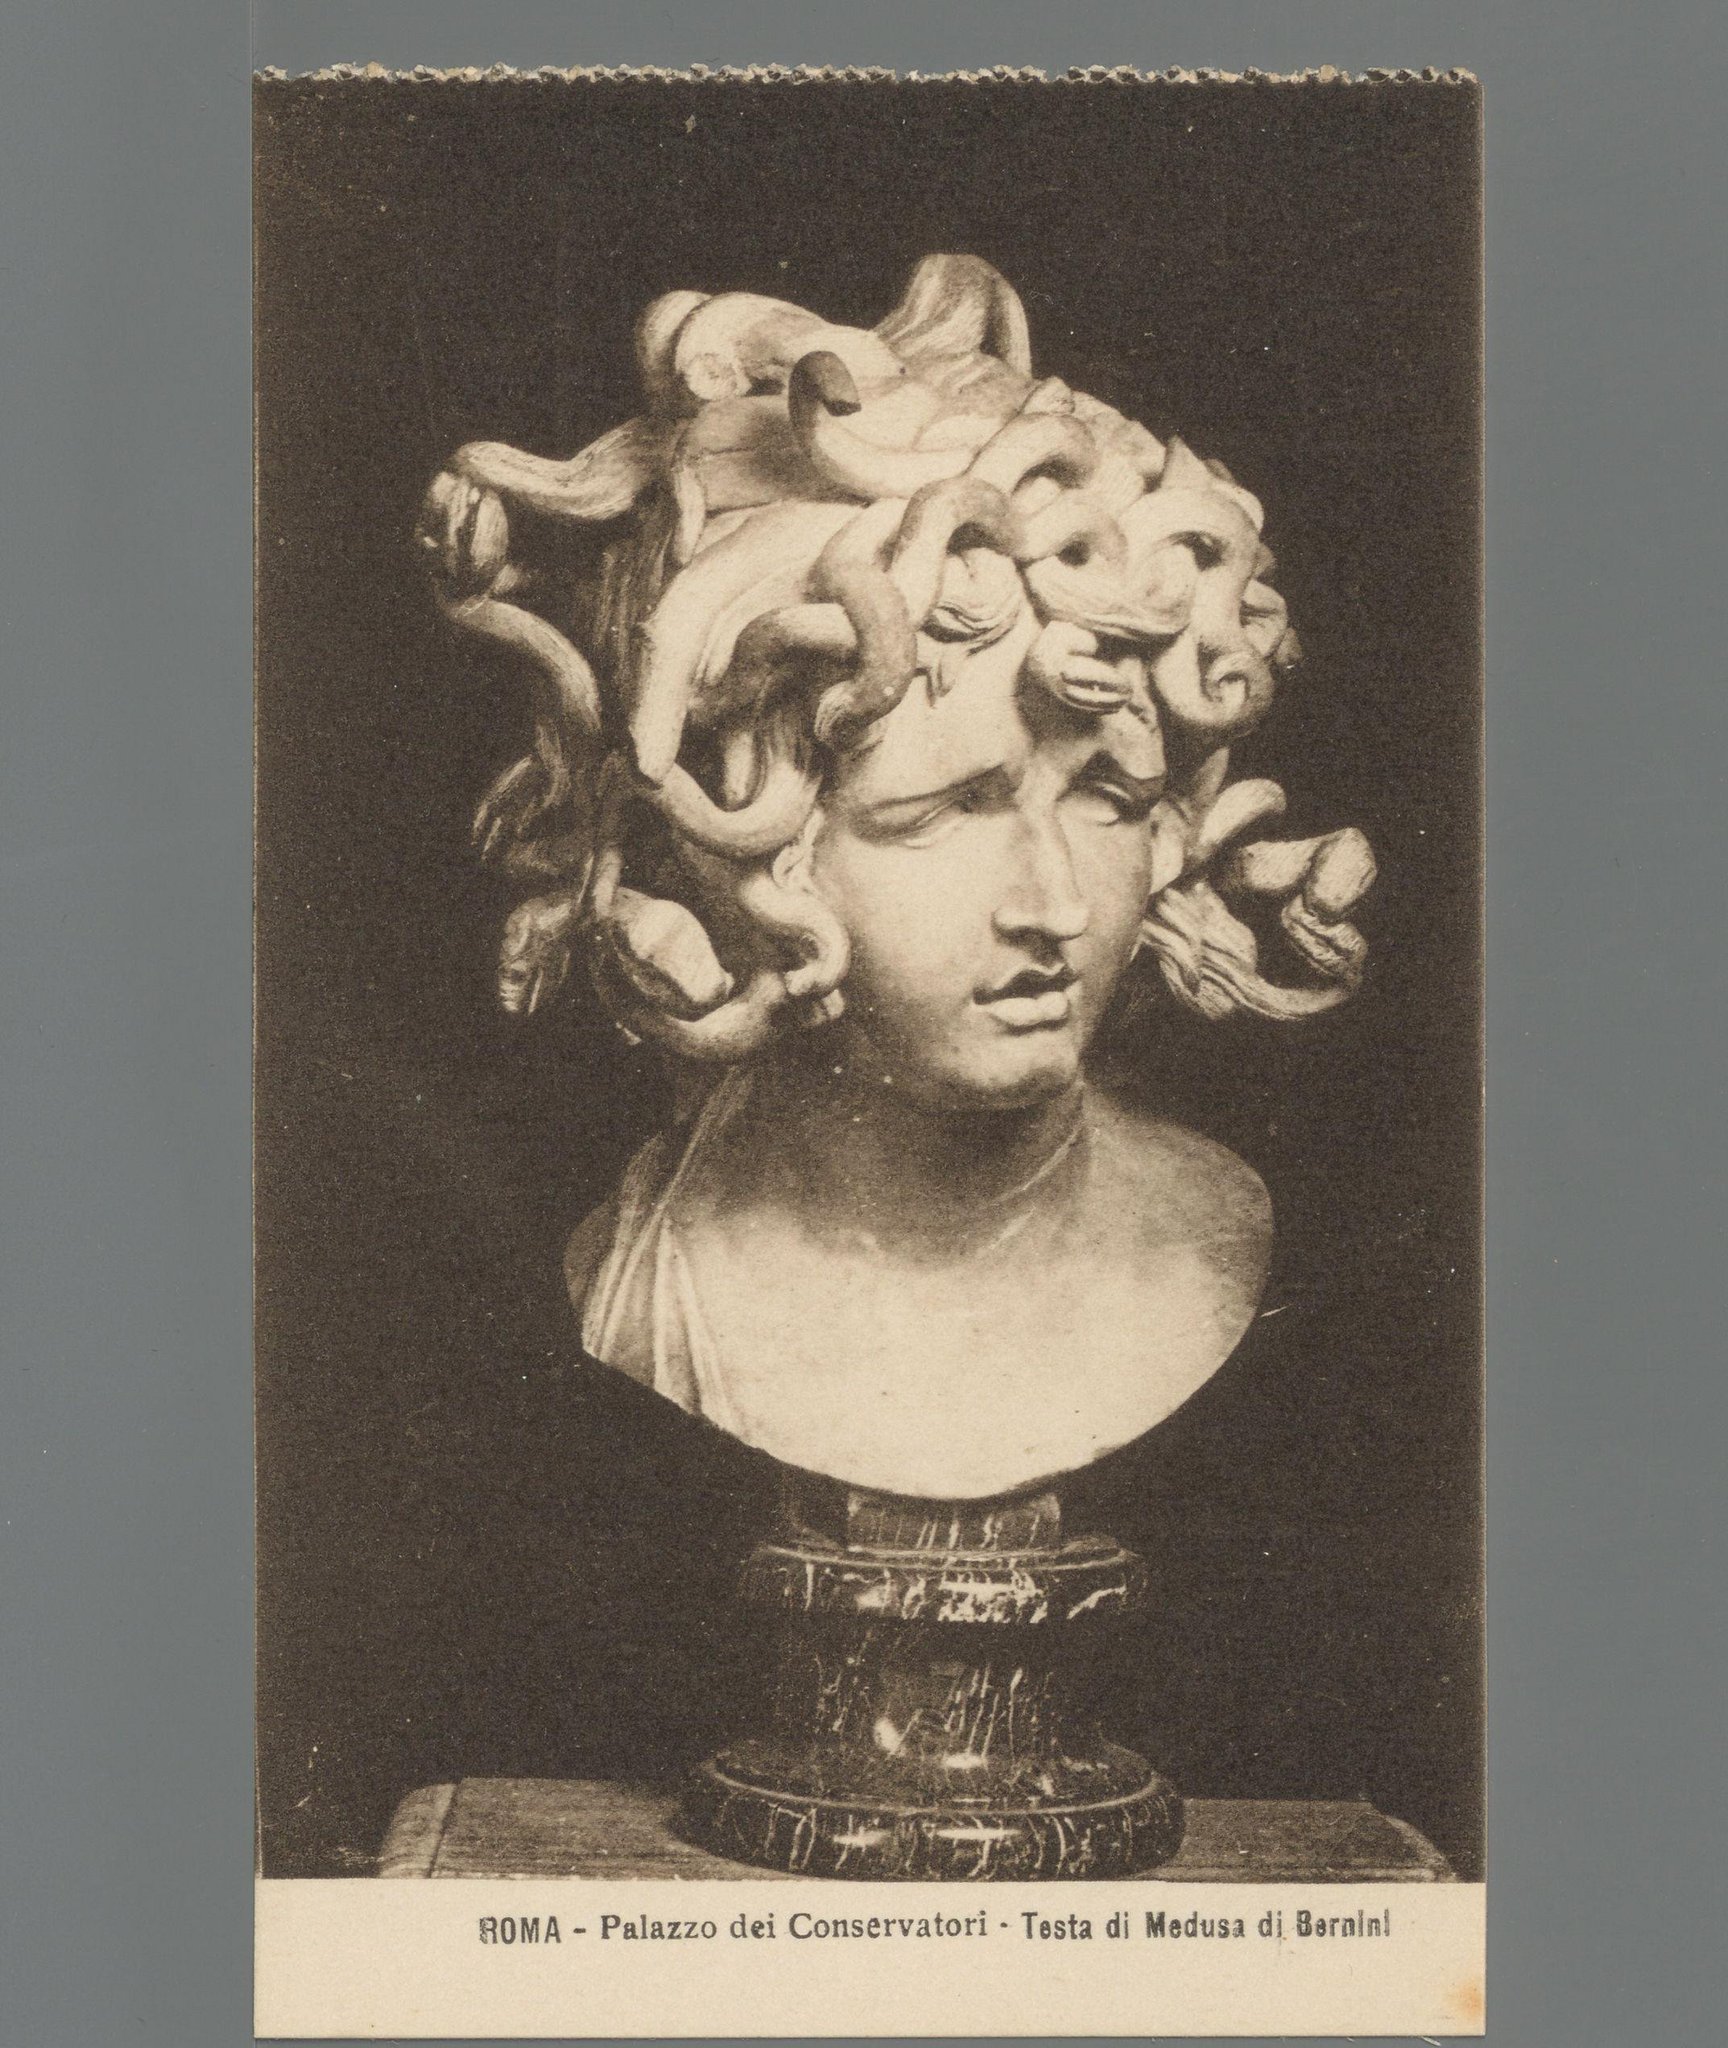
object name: photomechanical print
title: Roma - Palazzo dei Conservatori - Testa di Medusa di Bernini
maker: Anonymous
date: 1906-1930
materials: cardboard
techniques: photograph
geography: rome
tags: permanent exhibition, museum, sculpture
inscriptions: collector's mark: ‘AFE v S’